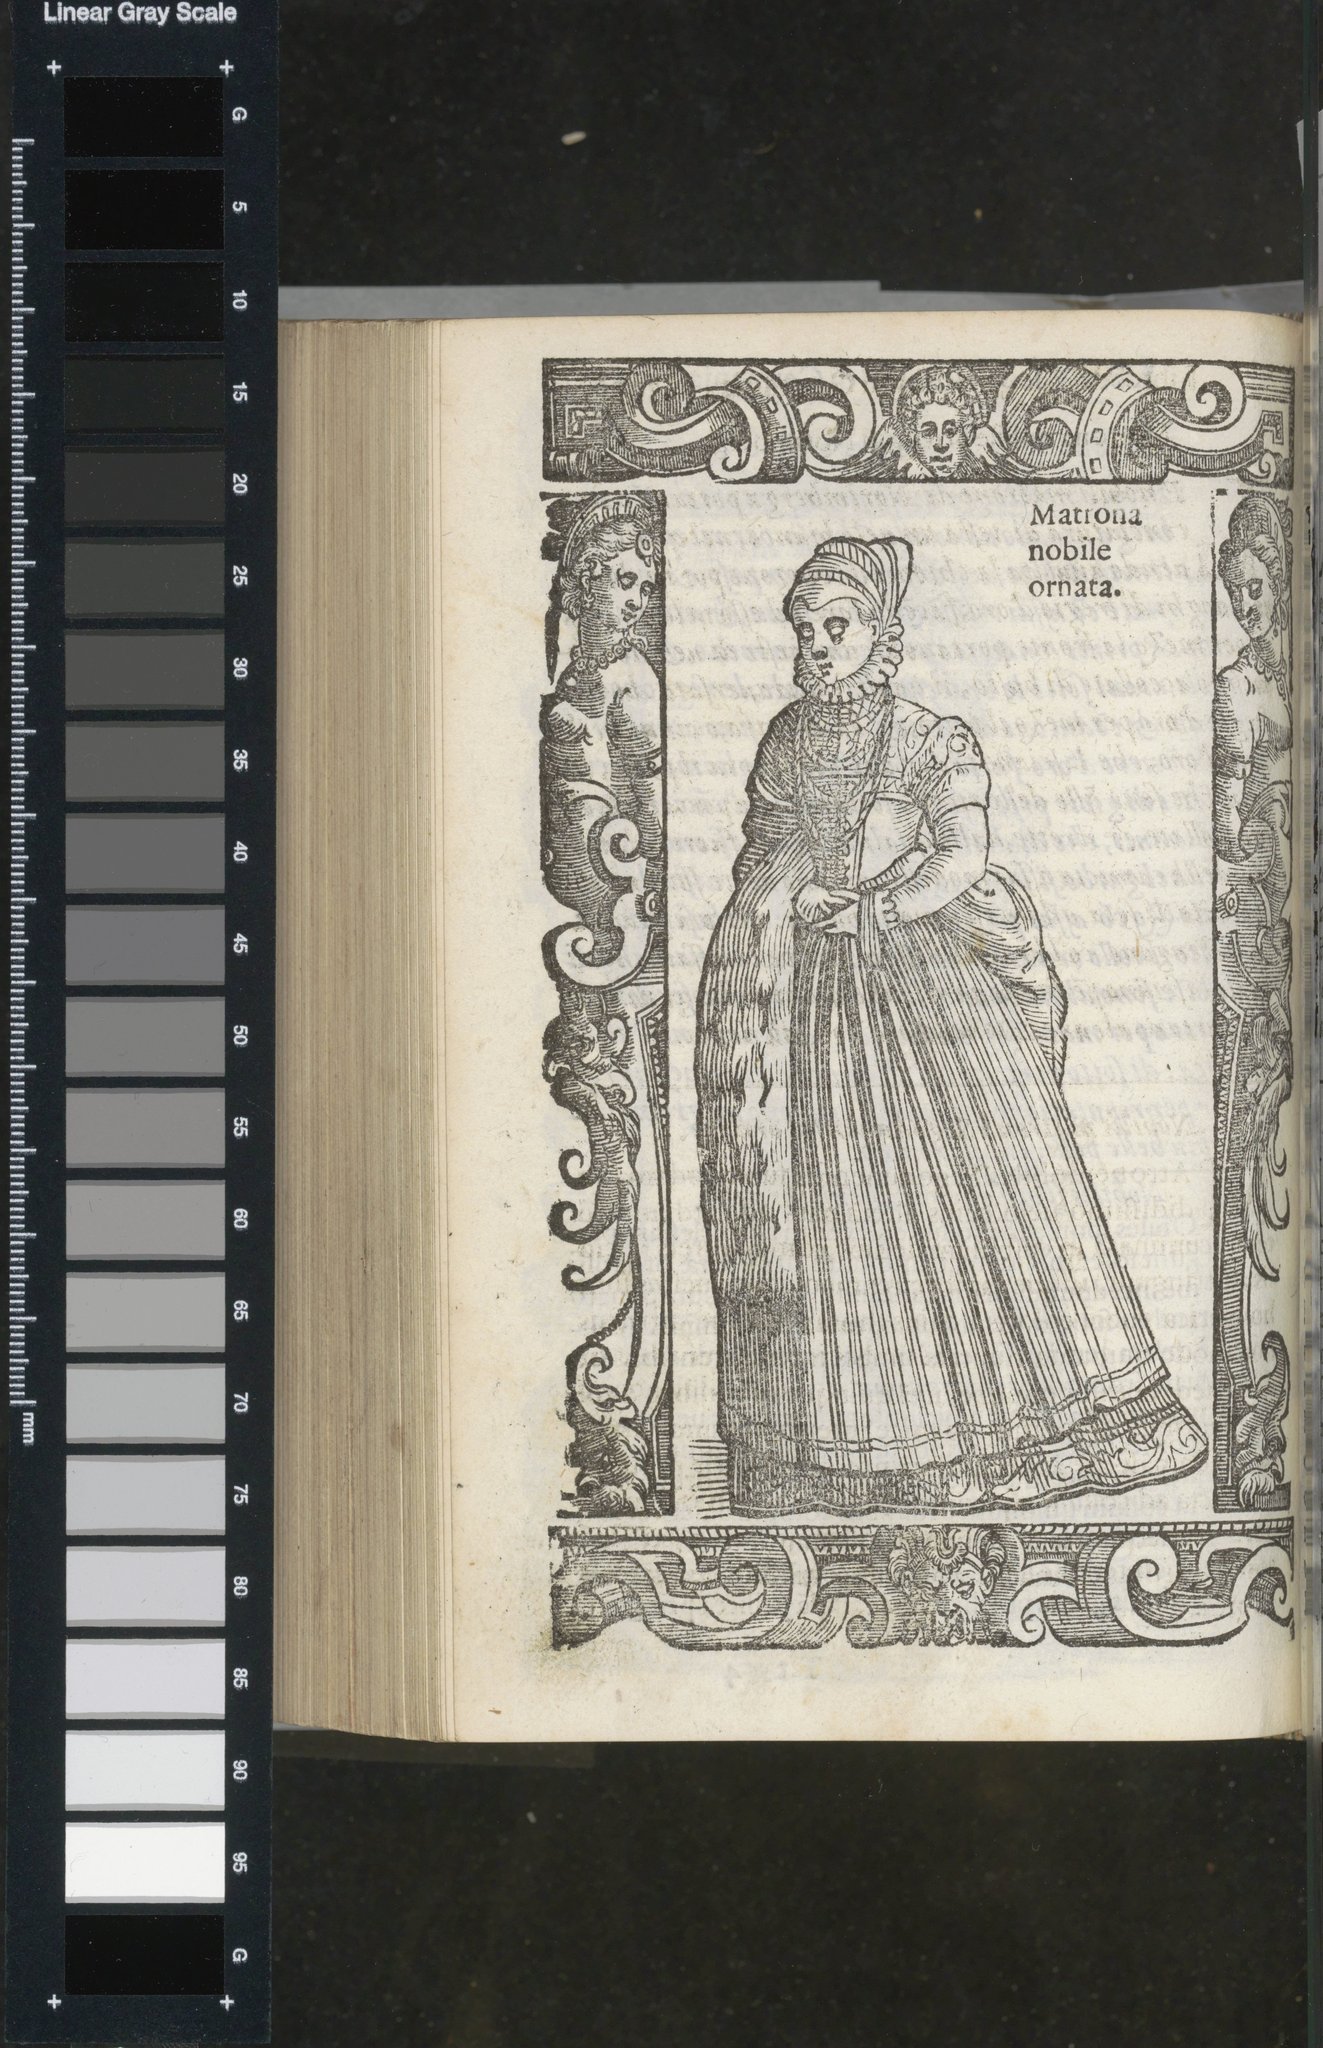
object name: costume print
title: Habiti antichi, et moderni di tutto il mondo...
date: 1598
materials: paper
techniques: woodcut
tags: fashion plates